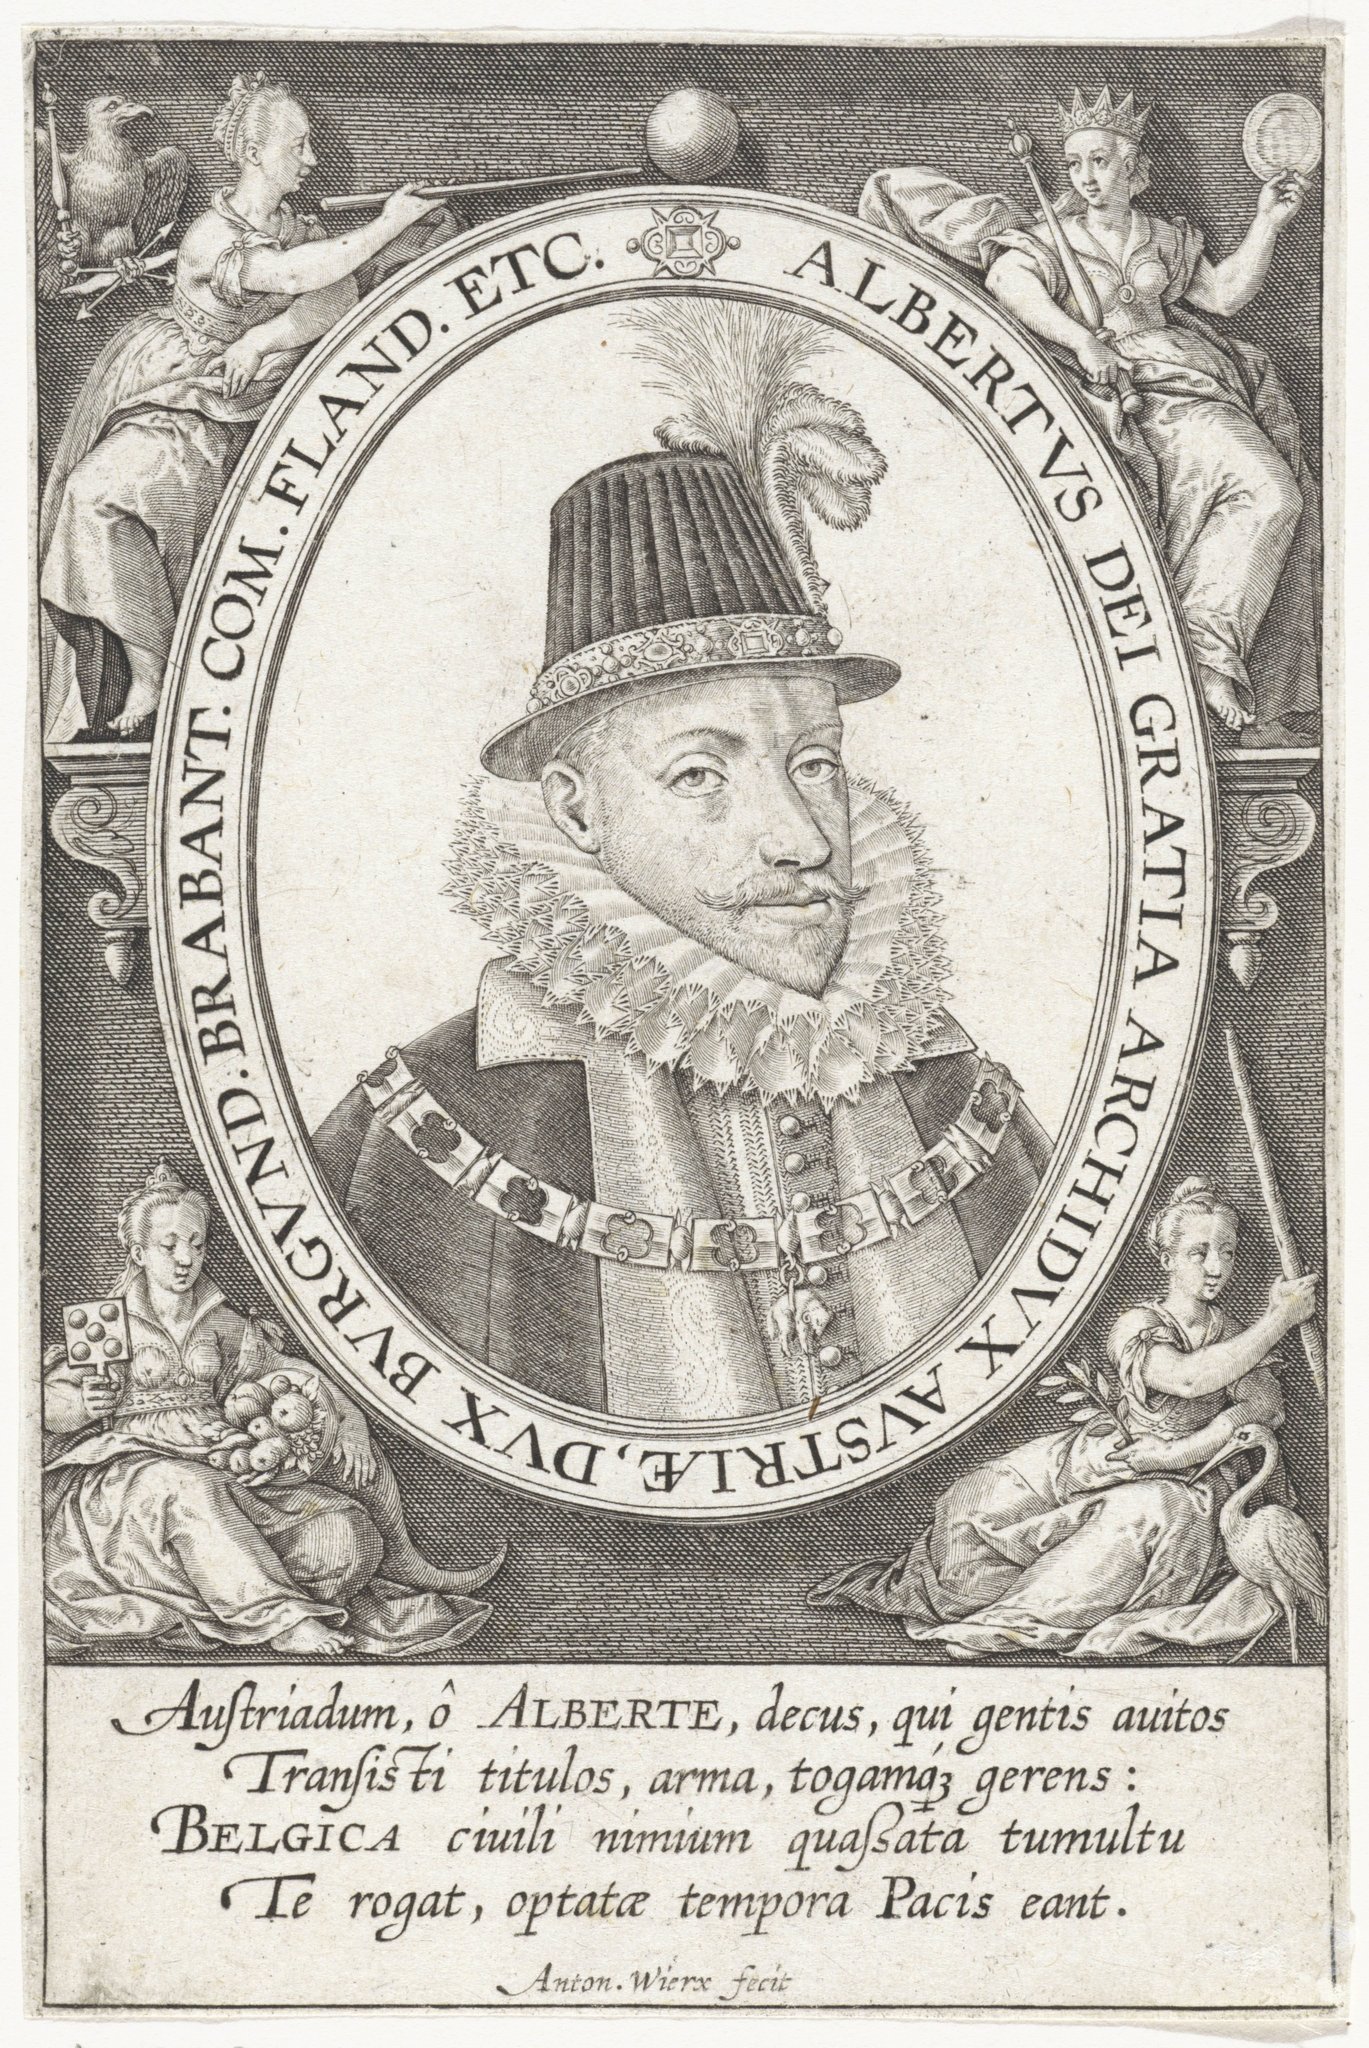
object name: print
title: Portret van Albrecht, aartshertog van Oostenrijk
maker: antonie wierix (ii)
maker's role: draughtsman, print maker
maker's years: 1555-1604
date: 1598-1604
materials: paper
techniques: engraving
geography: antwerp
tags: brussels, albrecht aartshertog van oostenrijk, knighthood order of the golden fleece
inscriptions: collector's mark: Lugt 2228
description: Busteportret van Albrecht, aartshertog van Oostenrijk. Hij draagt een keten met de Orde van het Gulden Vlies. In de hoeken allegorische vrouwfiguren. In de marge een vierregelig onderschrift in het Latijn.